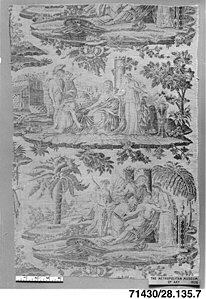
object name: piece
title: Numa Pompilus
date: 1825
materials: cotton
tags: human figures,trees